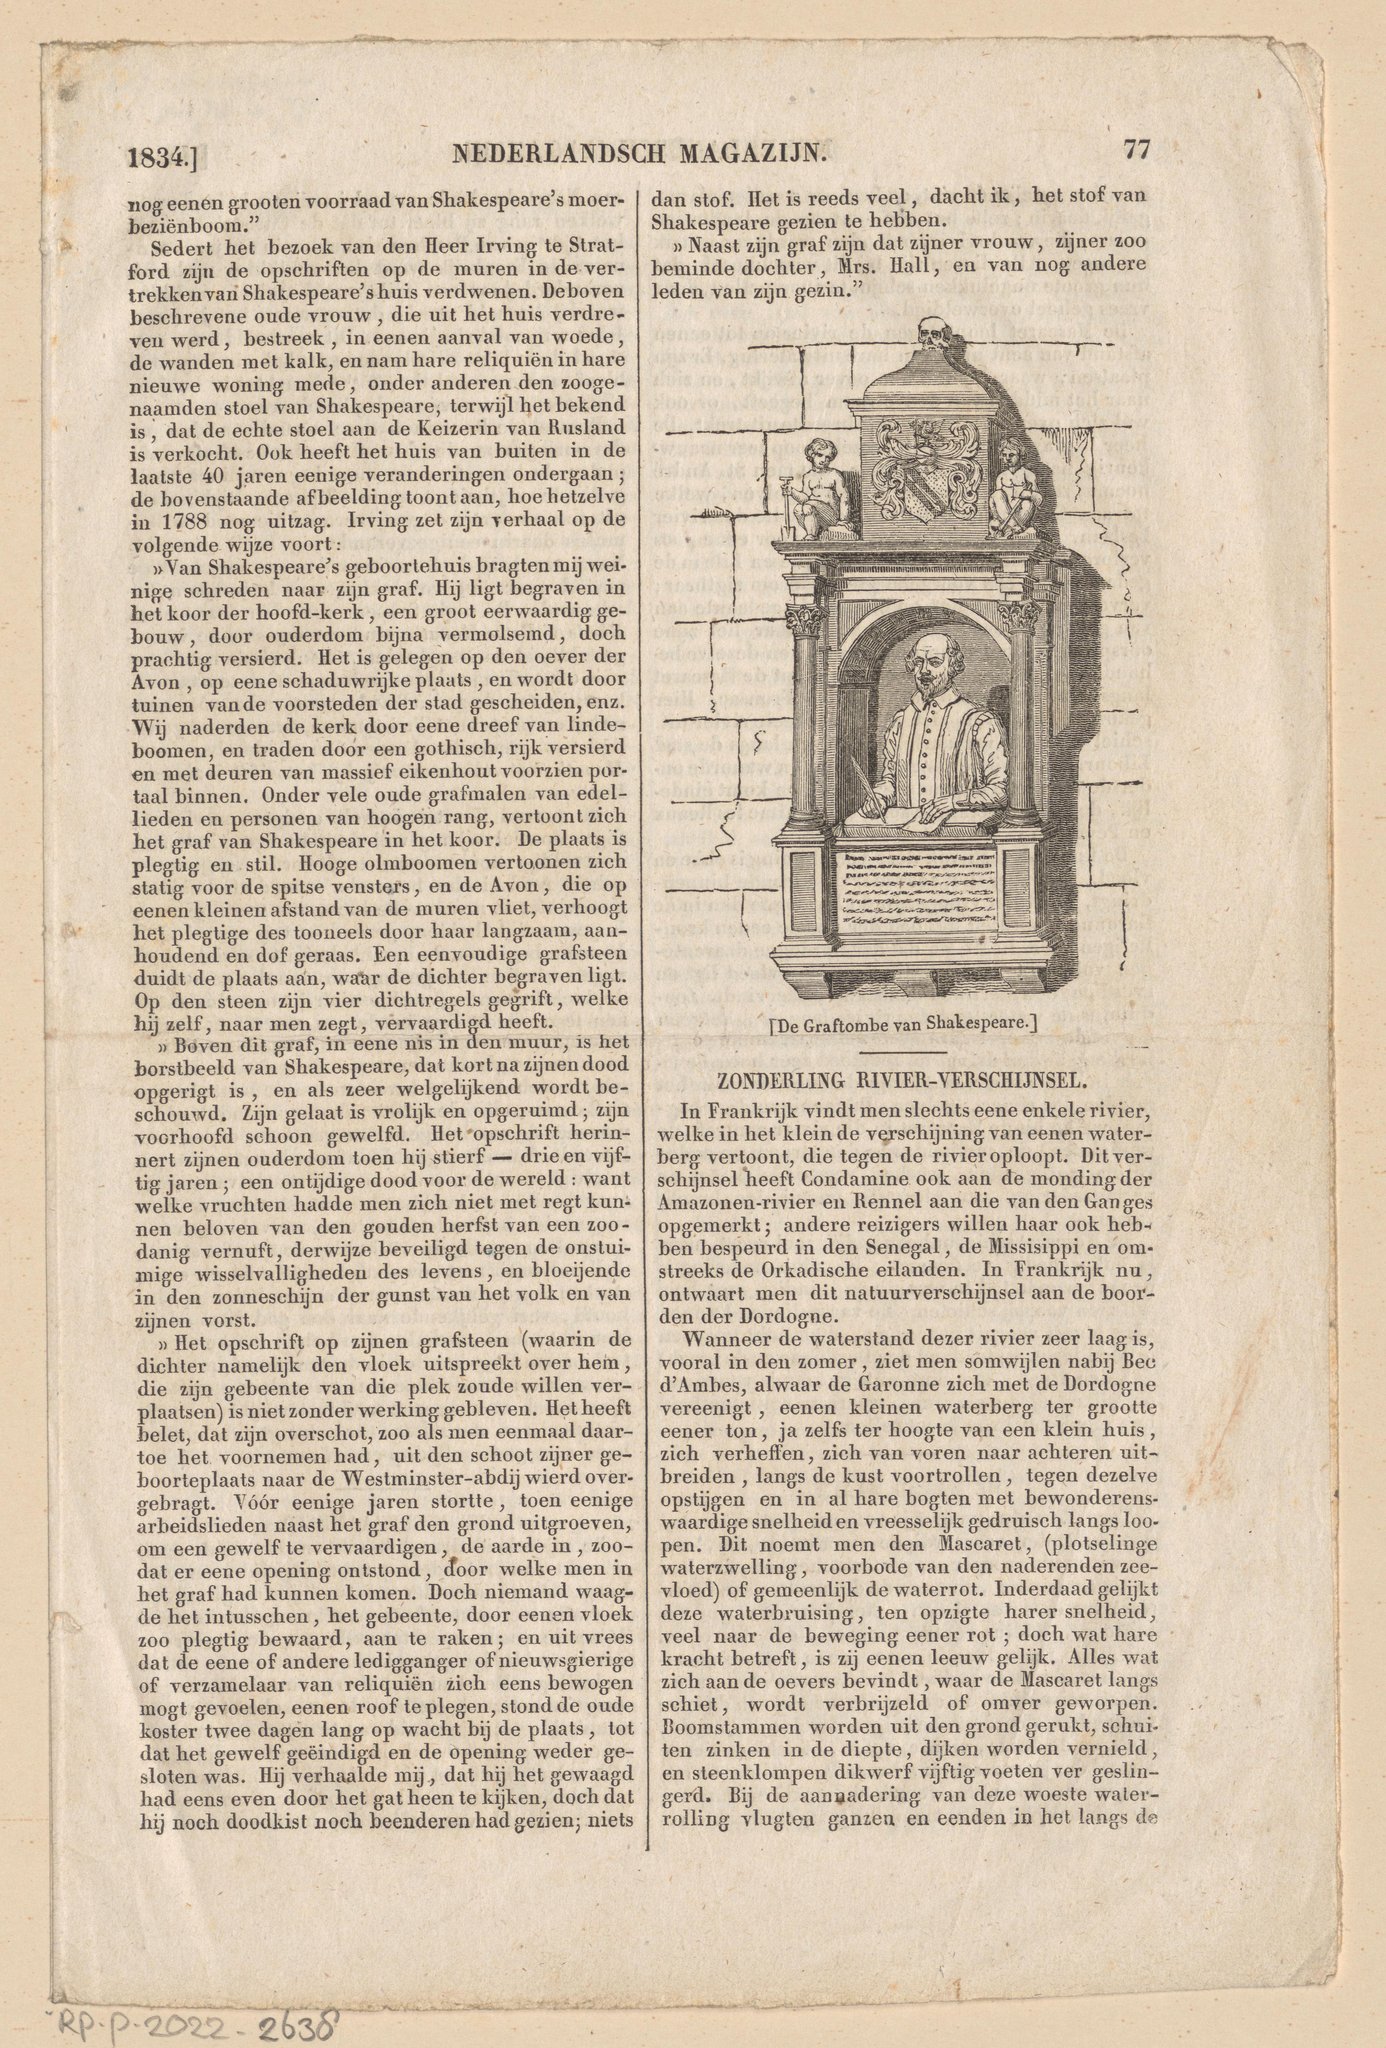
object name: page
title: Portret van William Shakespeare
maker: Anonymous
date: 1834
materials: paper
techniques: letterpress printing, engraving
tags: william shakespeare, historical persons, portrait of a writer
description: Bladzijde uit: Nederlandsch magazijn, ter verspreiding van algemeene en nuttige kundigheden 1 (1834), maart 1834.